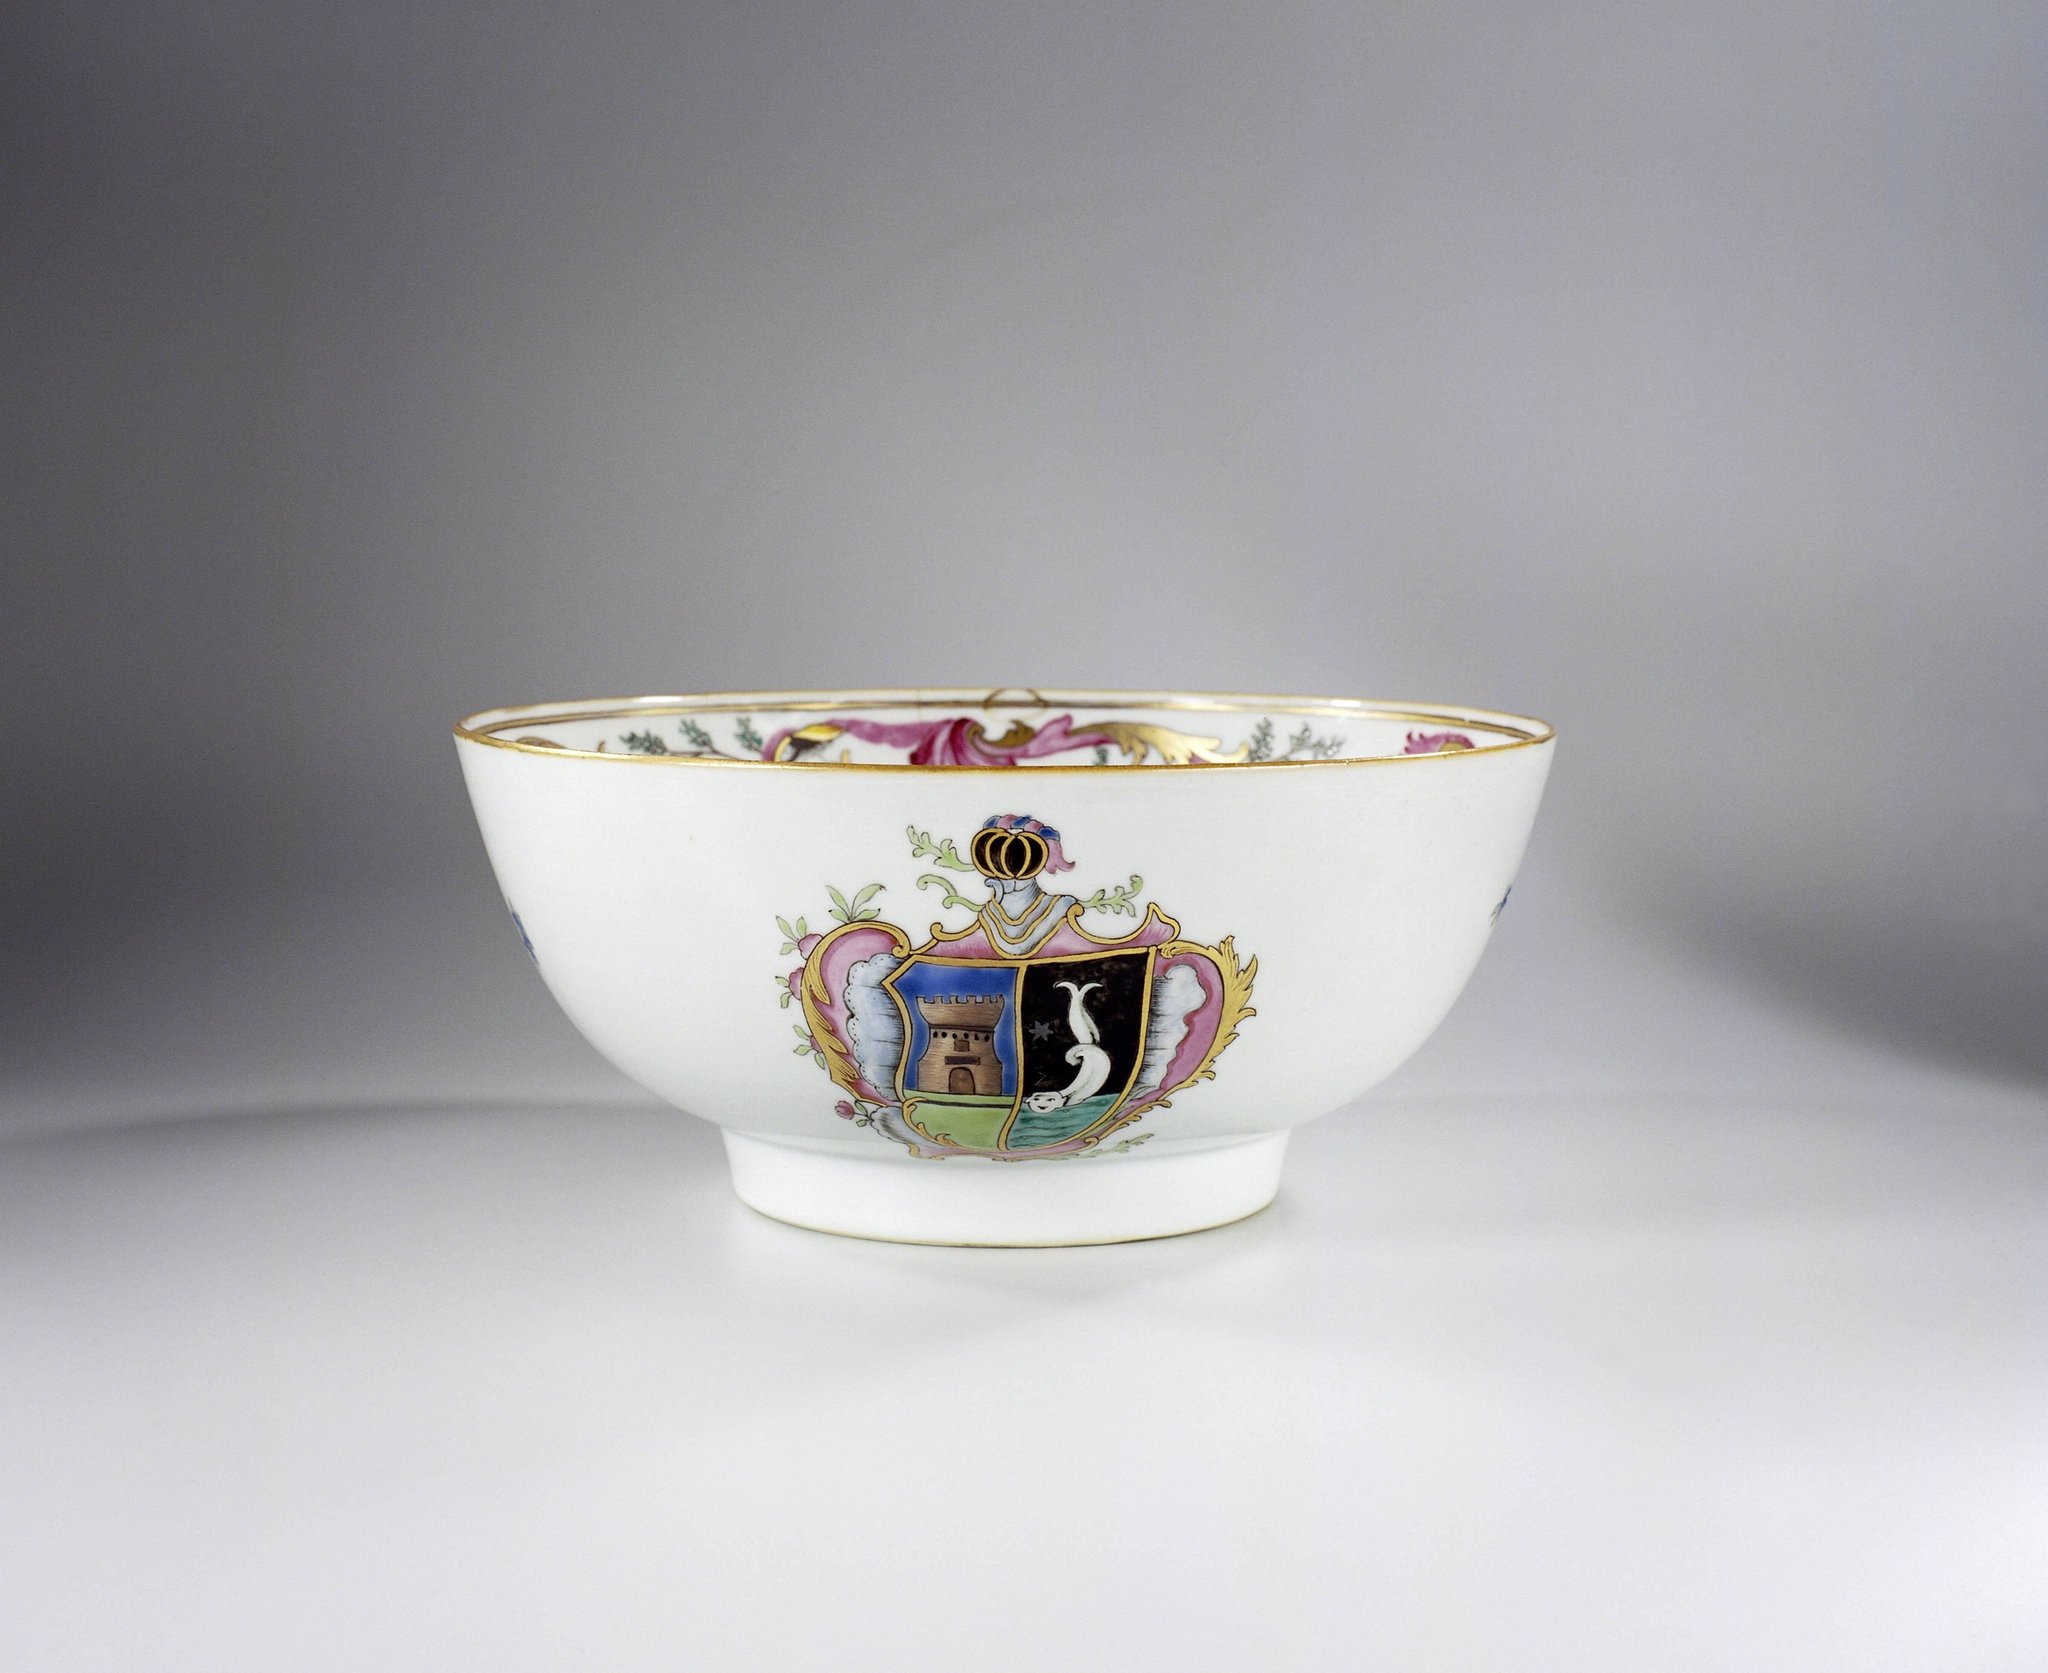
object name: bowl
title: Bowl with the arms of the Domburg family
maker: Anonymous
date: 1765-1770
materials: glaze, gold, paint, porcelain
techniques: firing, gilding, turning, vitrification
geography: china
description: Kom van porselein, beschilderd op het glazuur in blauw, rood, roze, groen, geel, bruin, zwart en goud. Op de buitenwand tweemaal het wapen van de familie Domburg in rococo-stijl. Het wapen is verdeeld in twee delen: 1. op een blauwe achtergrond een toren op een groene ondergrond, 2. op een zwarte achtergrond een dolfijn met het hoofd van een mens. Links van de dolfijn is een ster afgebeeld. Er is geen helmteken, maar wel een kroon afgebeeld. Het dekkleed bestaat uit een rocialle-decoratie en takken. Tussen de wapens bloemtakken. De binnnenrand met een decoratieve band met schelpen, ranken en zonnen. Een barst in de rand van de kom. Wapenporselein met emailkleuren.